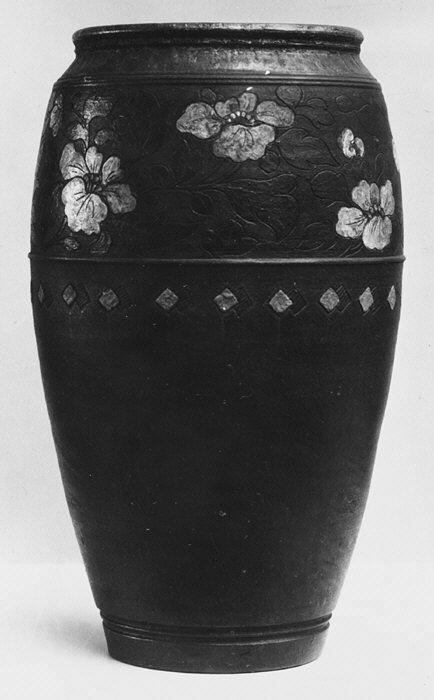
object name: vase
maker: haviland & co.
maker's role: manufactory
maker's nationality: american and french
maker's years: 1864-1931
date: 1882-1886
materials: clay, gilt, stoneware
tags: flowers